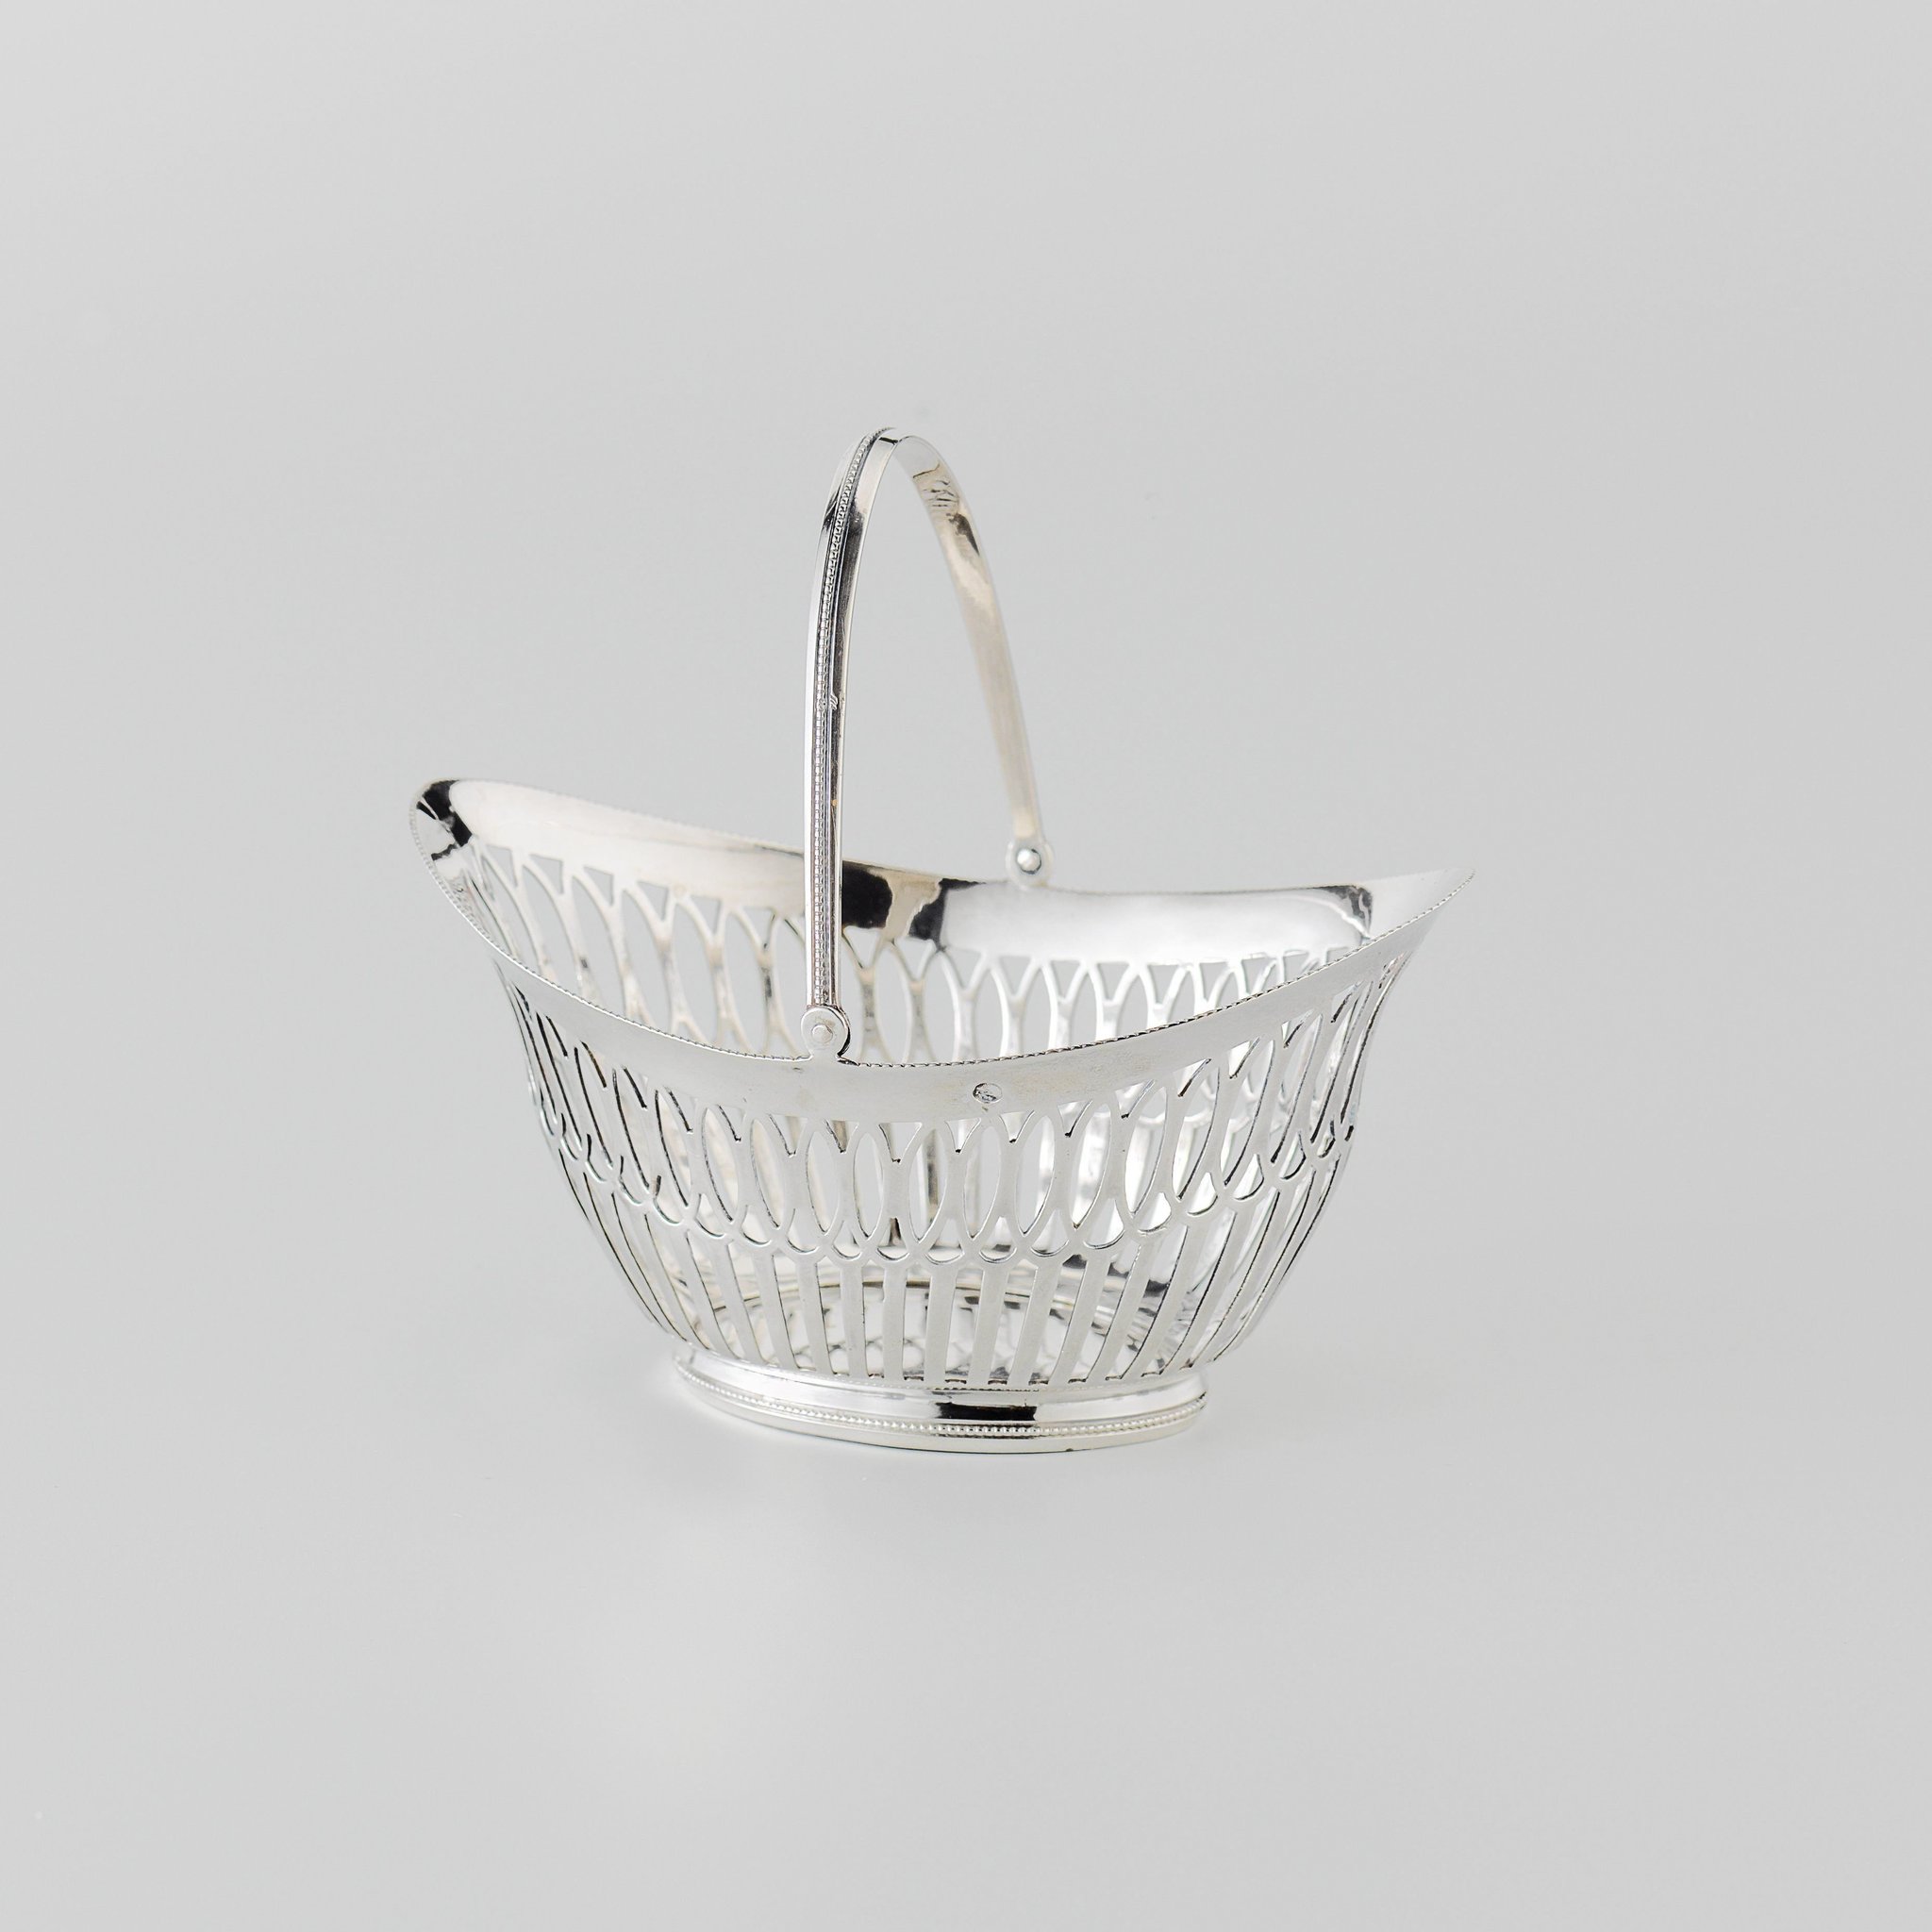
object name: bonbonmand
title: Bonbonmand van zilver, schuitvormig met opengewerkte rand.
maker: p.g. tombrink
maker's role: silversmith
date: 1812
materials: silver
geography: netherlands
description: Bonbonmand van zilver, schuitvormig met opengewerkte rand.